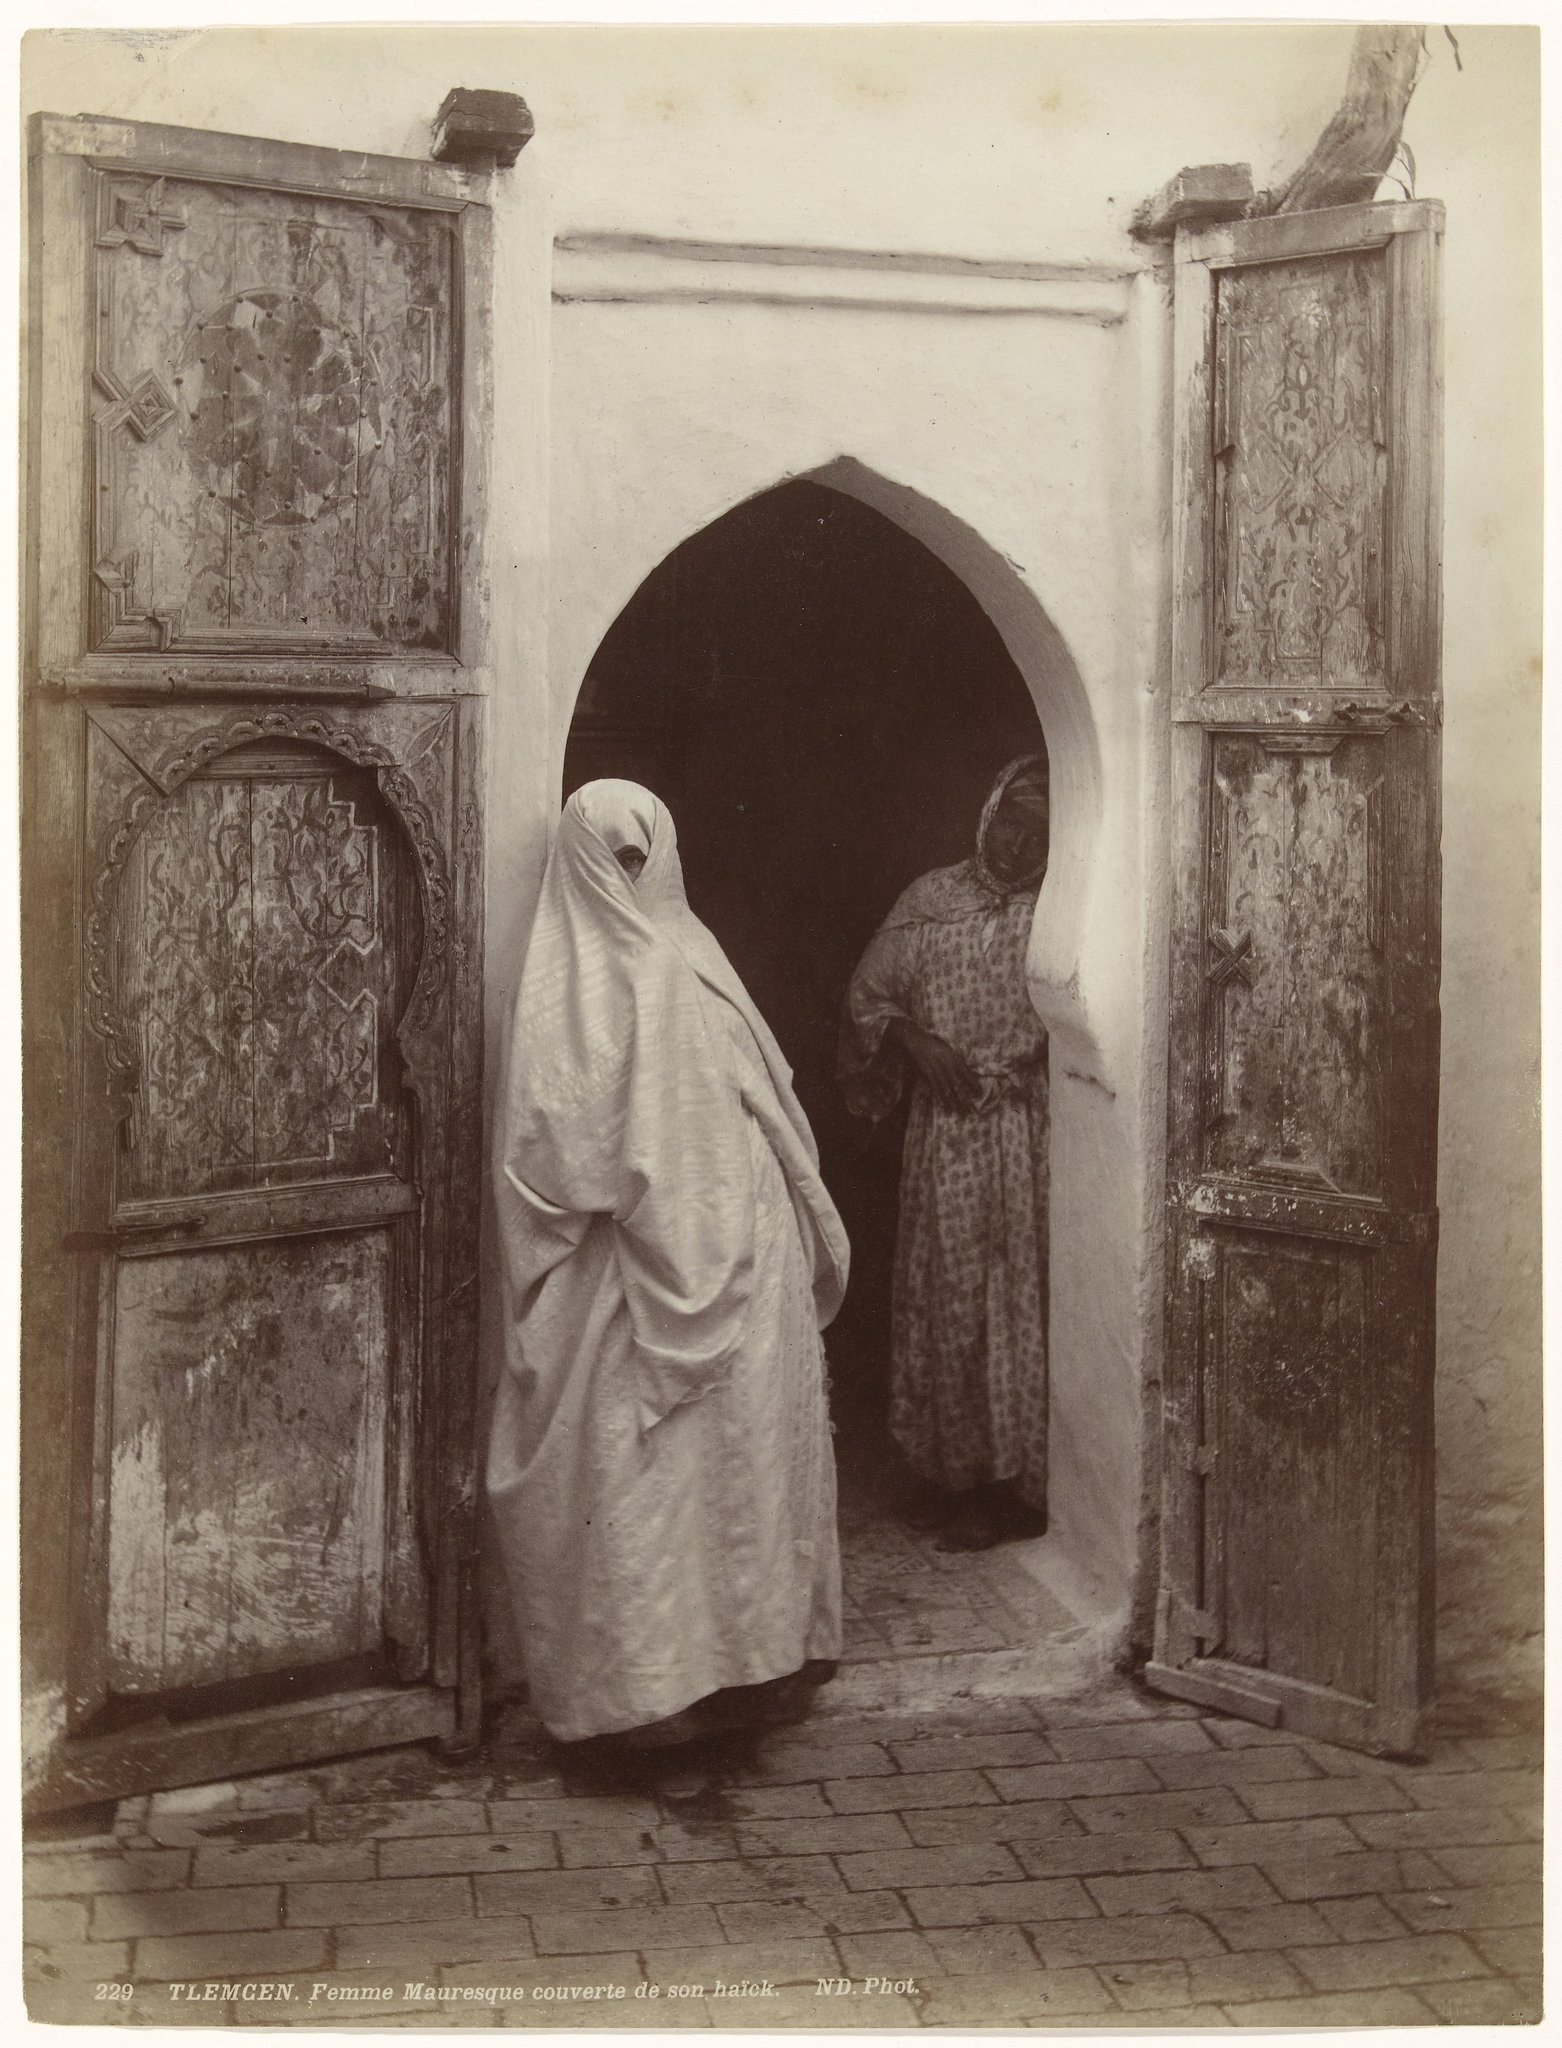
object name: photograph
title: Twee vrouwen in een deuropening in Tlemcen, Algerije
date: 1900-1918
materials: paper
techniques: albumen print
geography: tlemcen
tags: adult woman, gate, entrance, veil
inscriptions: inscription: ‘229 Tlemcen. Femme Mauresque couverte de son haïck. ND. Phot.’